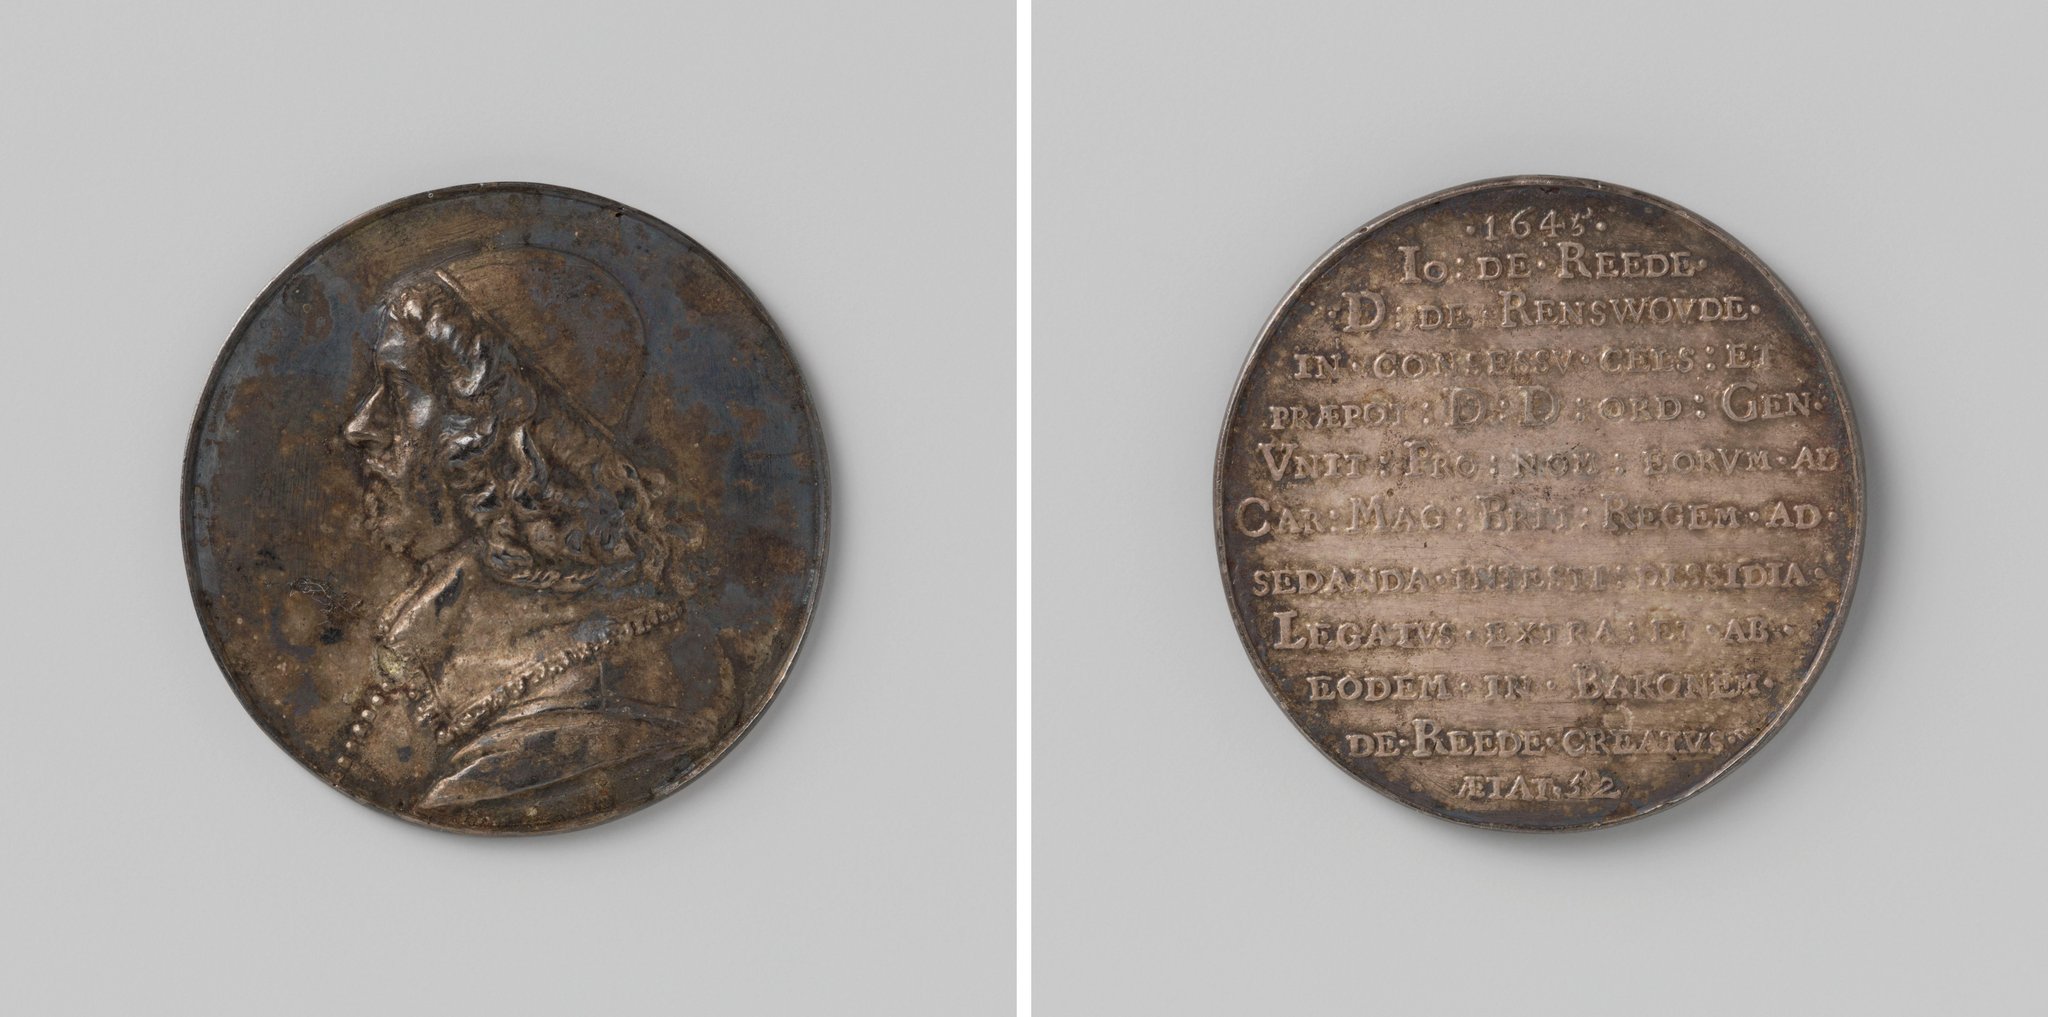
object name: history medal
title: Johan van Reede, heer van Renswoude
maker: thomas simon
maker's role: medailleur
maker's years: 1618-1665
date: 1645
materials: silver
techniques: casting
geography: london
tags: johan baron van reede van renswoude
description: Zilveren penning. Voorzijde: borststuk man. Keerzijde: opschrift.